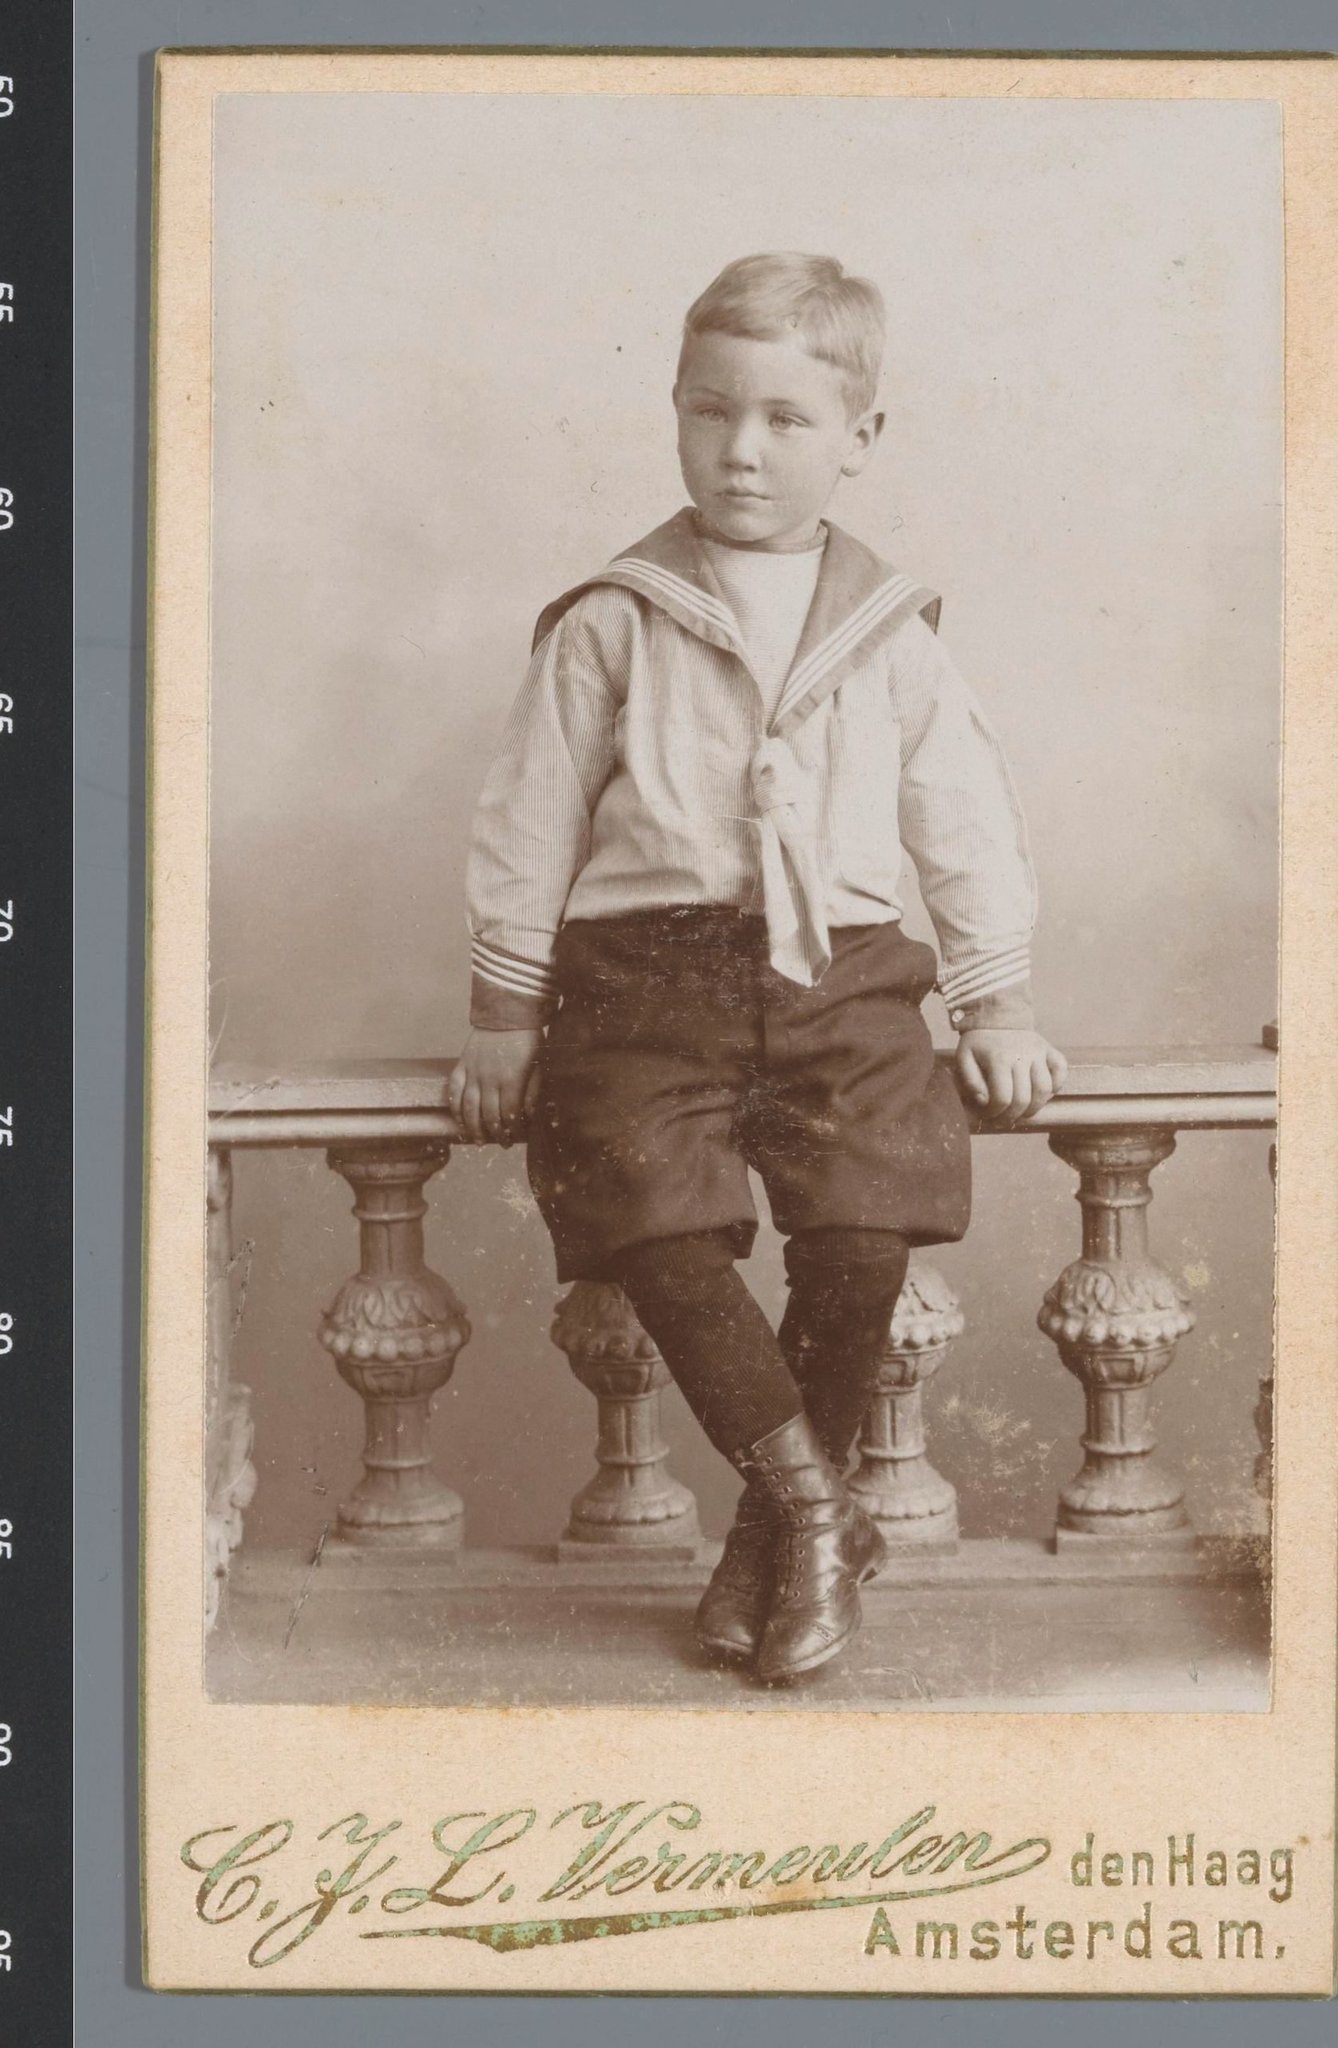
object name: photograph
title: Portret van een onbekende jongen in matrozenpak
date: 1890-1915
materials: cardboard, photographic support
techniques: collodion silver print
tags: ensemble of pieces of clothing: sailor suit, boy (child between toddler and youth), historical persons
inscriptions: inscription: ‘C. J. L. Vermeulen,/ Heiligenweg hoek Singel/ Heerenstraat 6/ Telephoon No. 2339 en 2340./ Amsterdam./ Toussaintkade 11./ den Haag/ Intercommunal Telephoon: 774.’